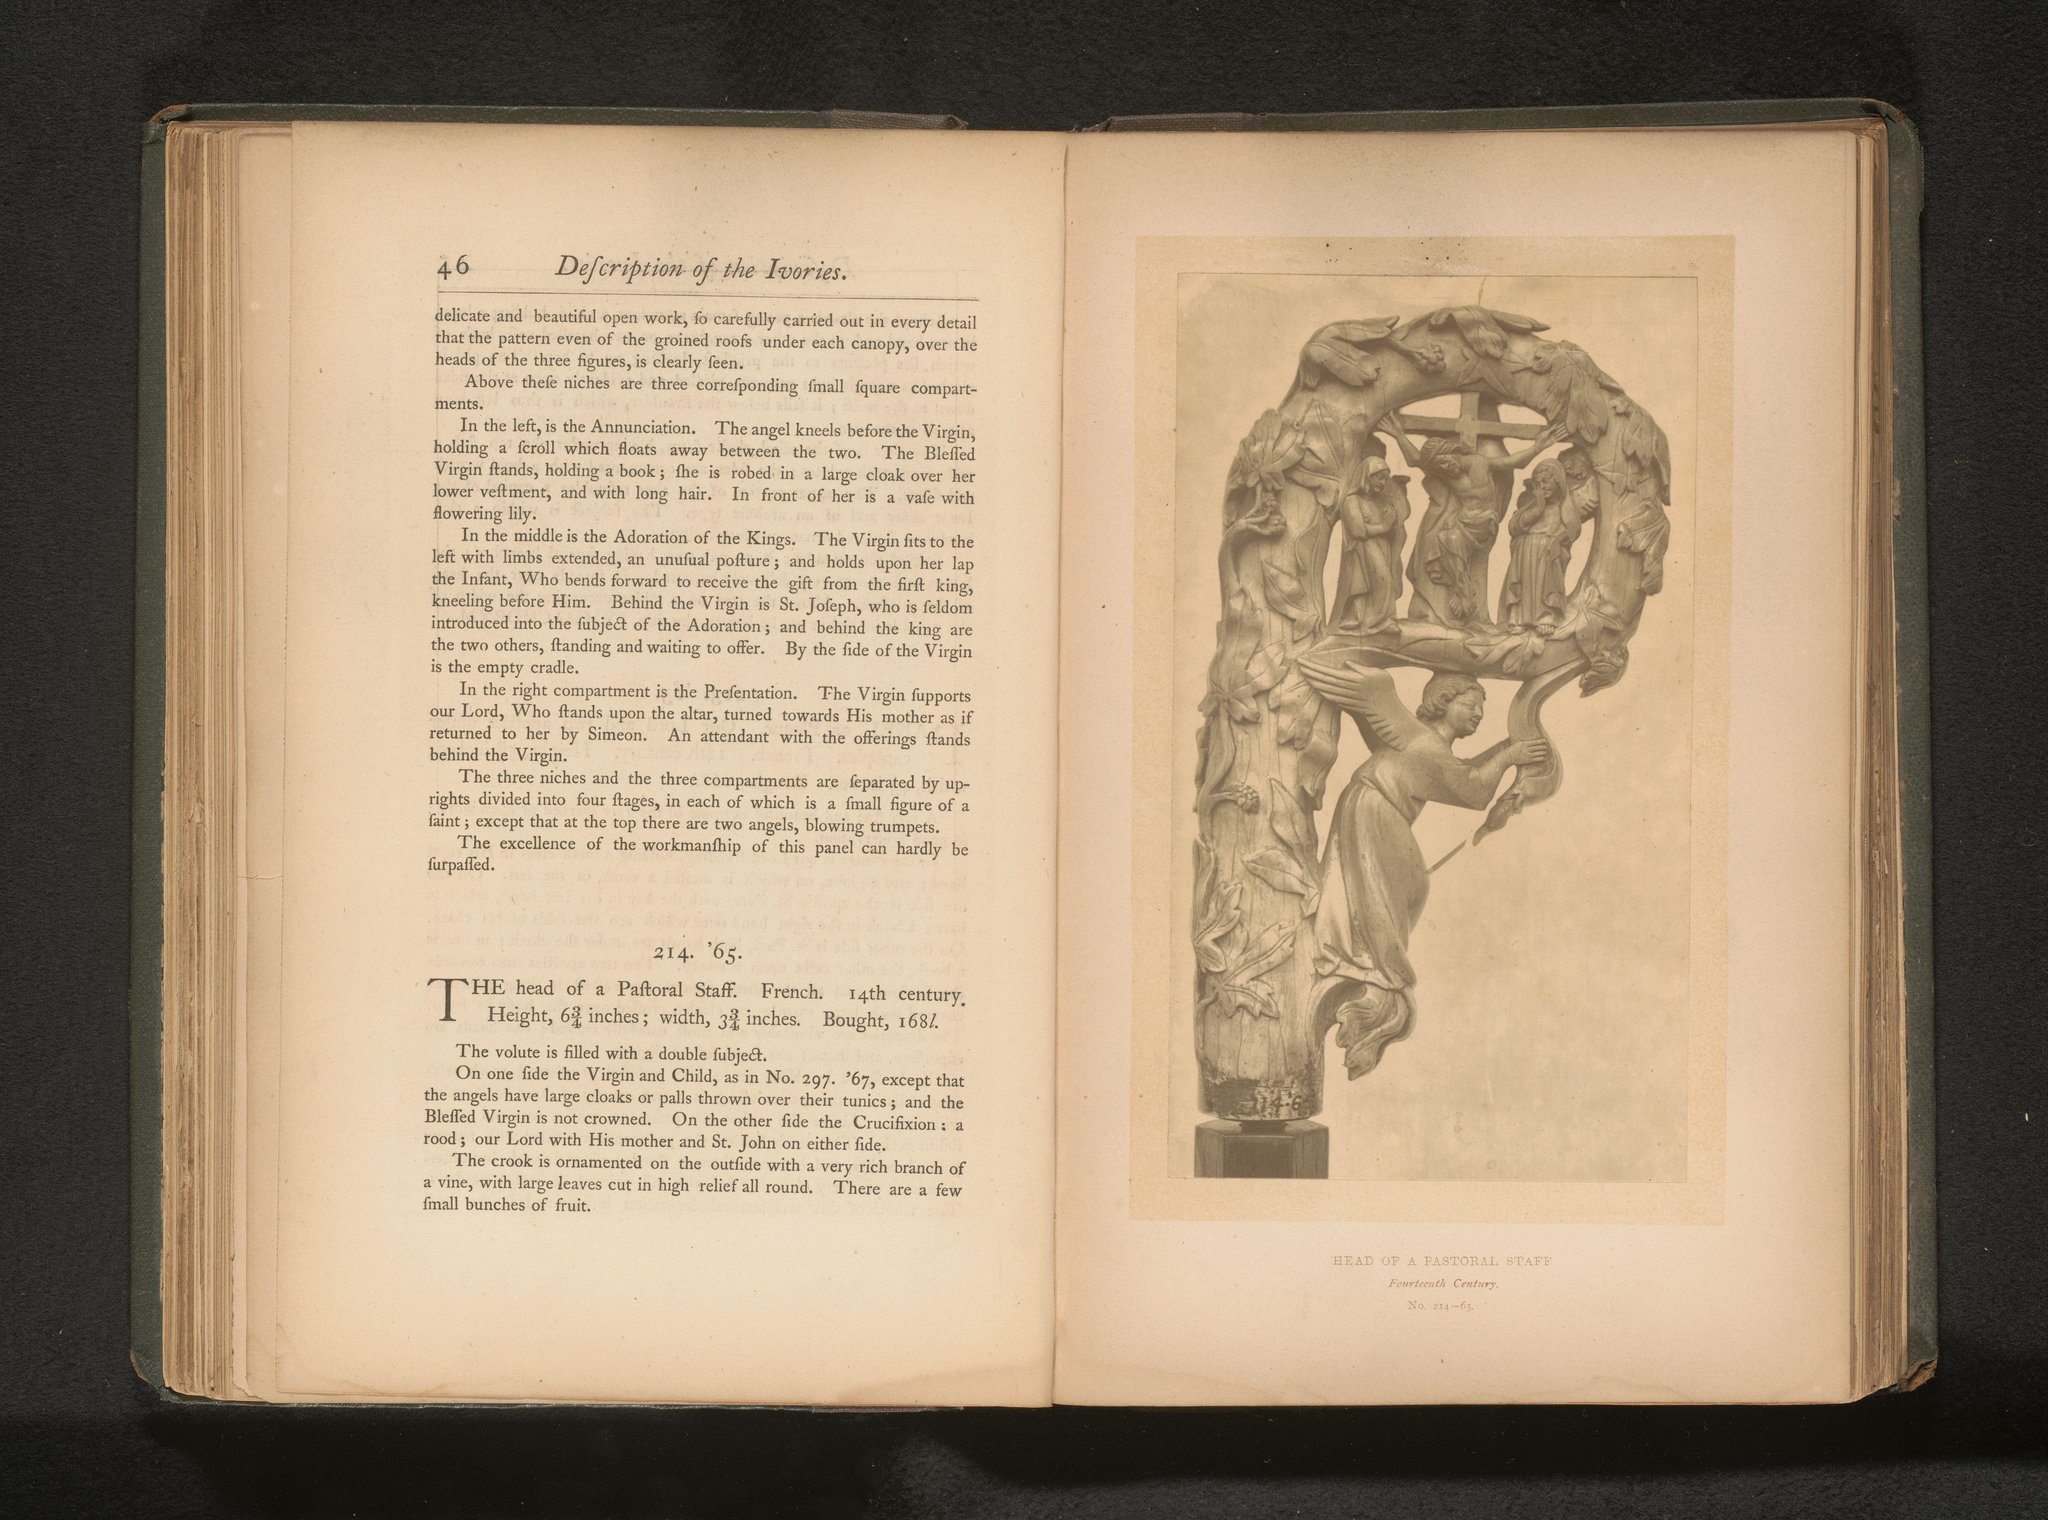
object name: photomechanical print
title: Head of a pastoral staff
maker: Anonymous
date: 1867-1872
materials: paper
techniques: woodburytype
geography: london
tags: insignia of bishop, e.g. mitre, crozier, sculpture (+ relief ~ sculpture)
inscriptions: inscription: ‘Fourteenth Century.’, number: ‘No. 214-65.’